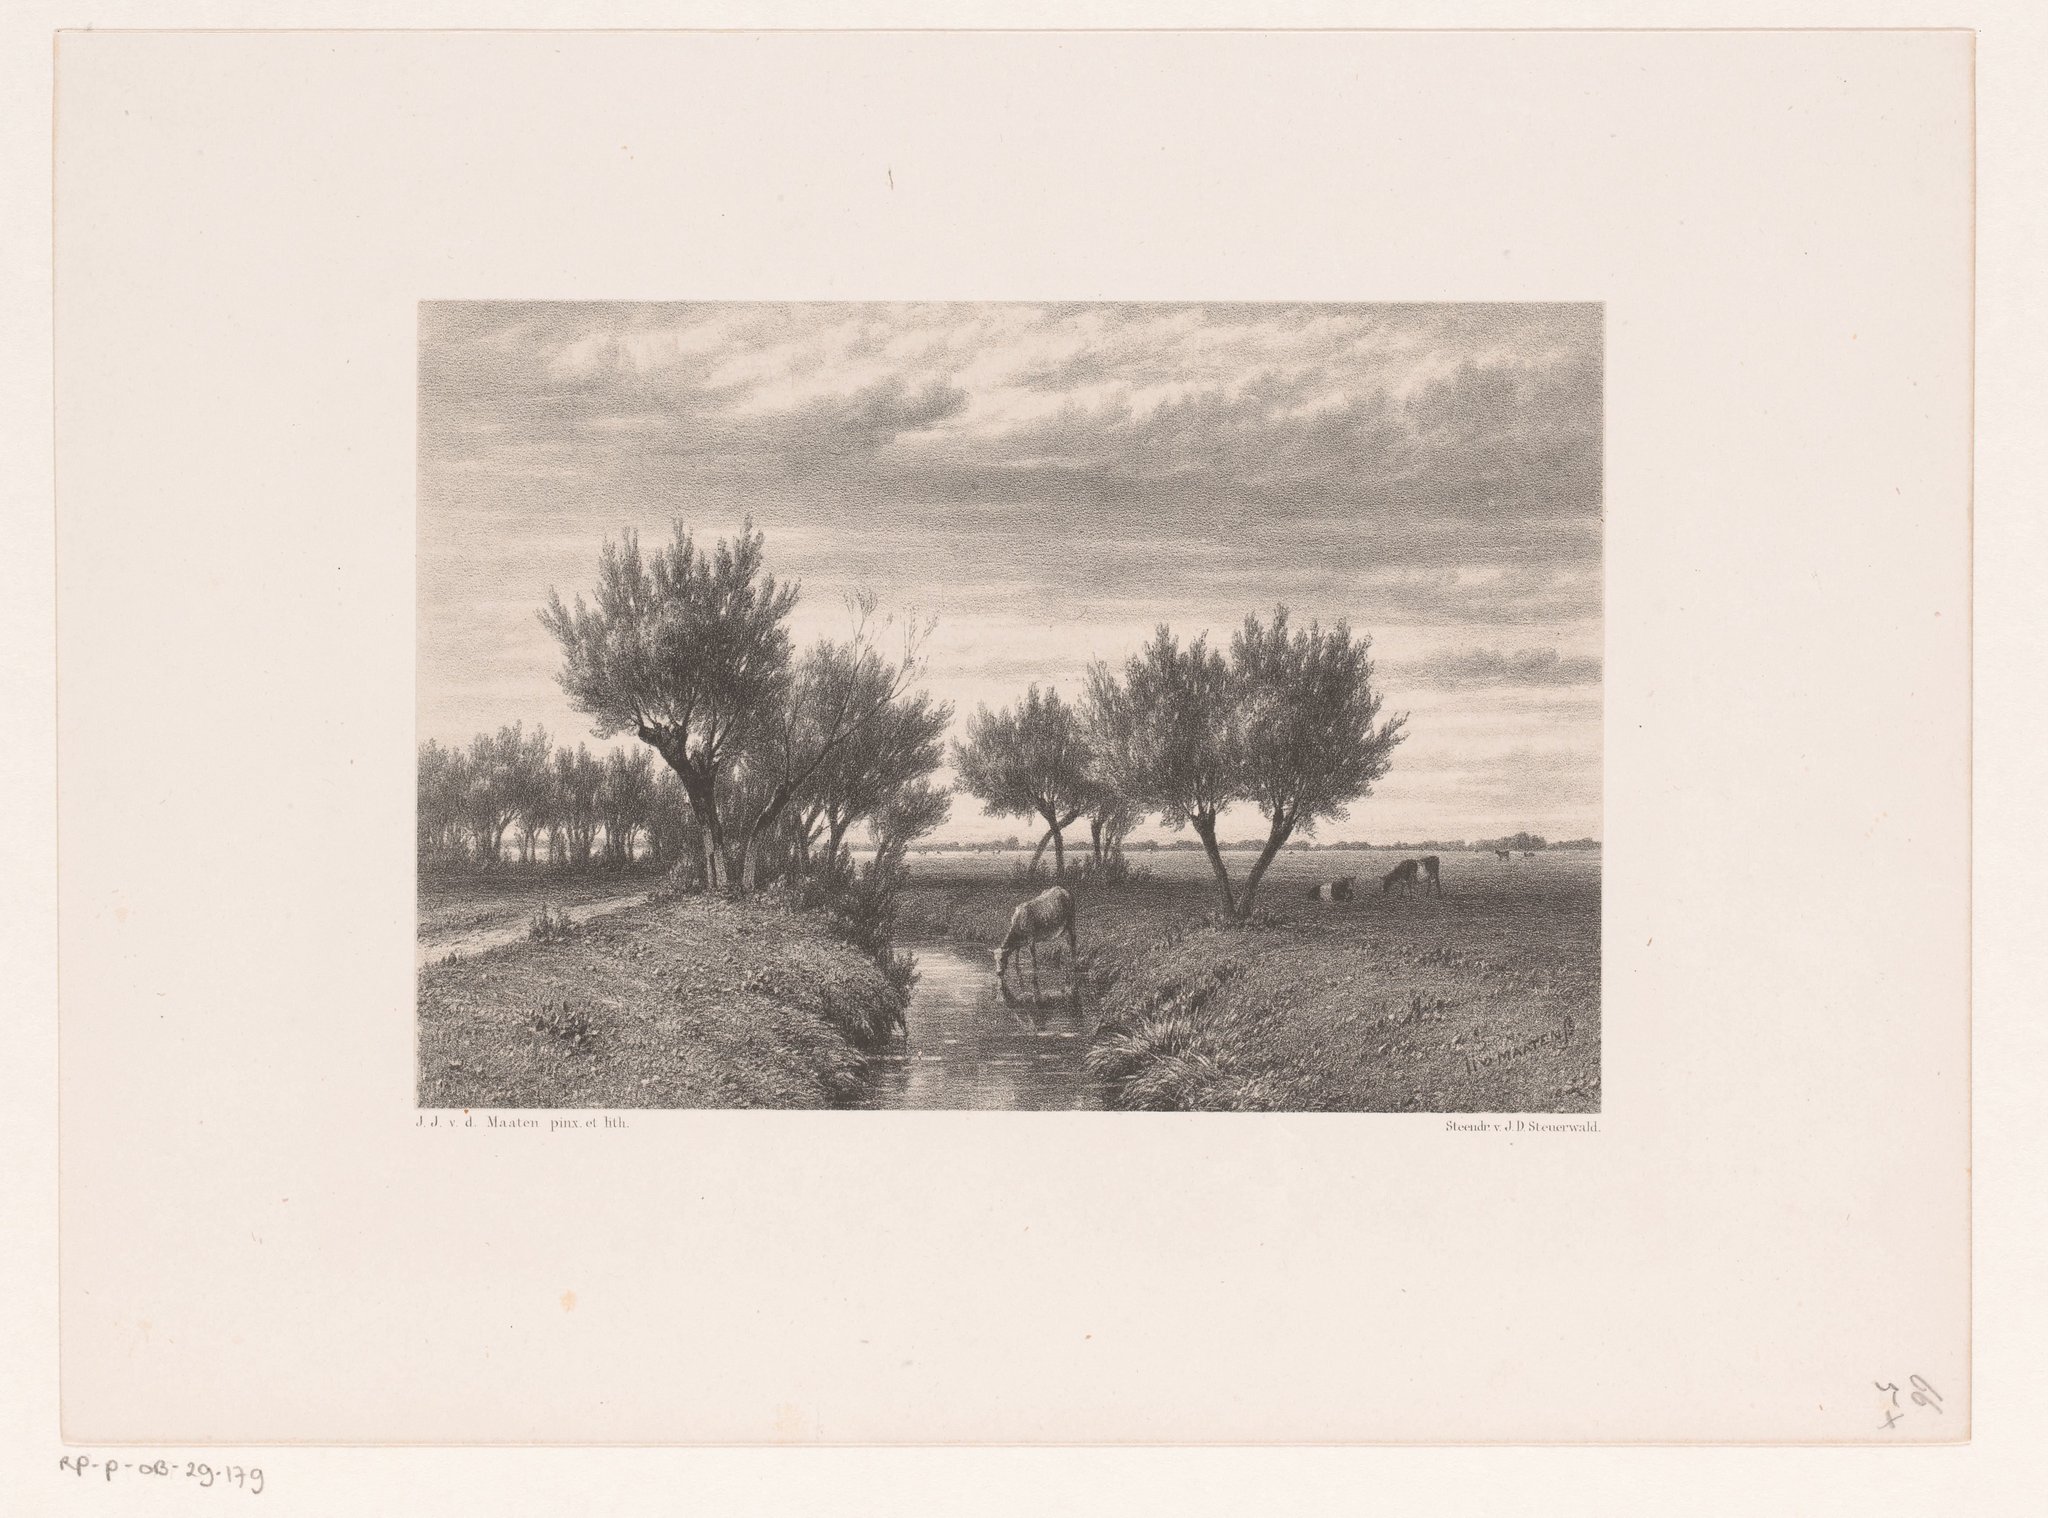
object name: print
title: Landschap met sloot en koeien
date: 1830-1863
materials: paper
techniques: lithograph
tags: cow, meadow, pasture, small canal, ditch (+ landscape with figures, staffage)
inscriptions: collector's mark: Lugt 2228